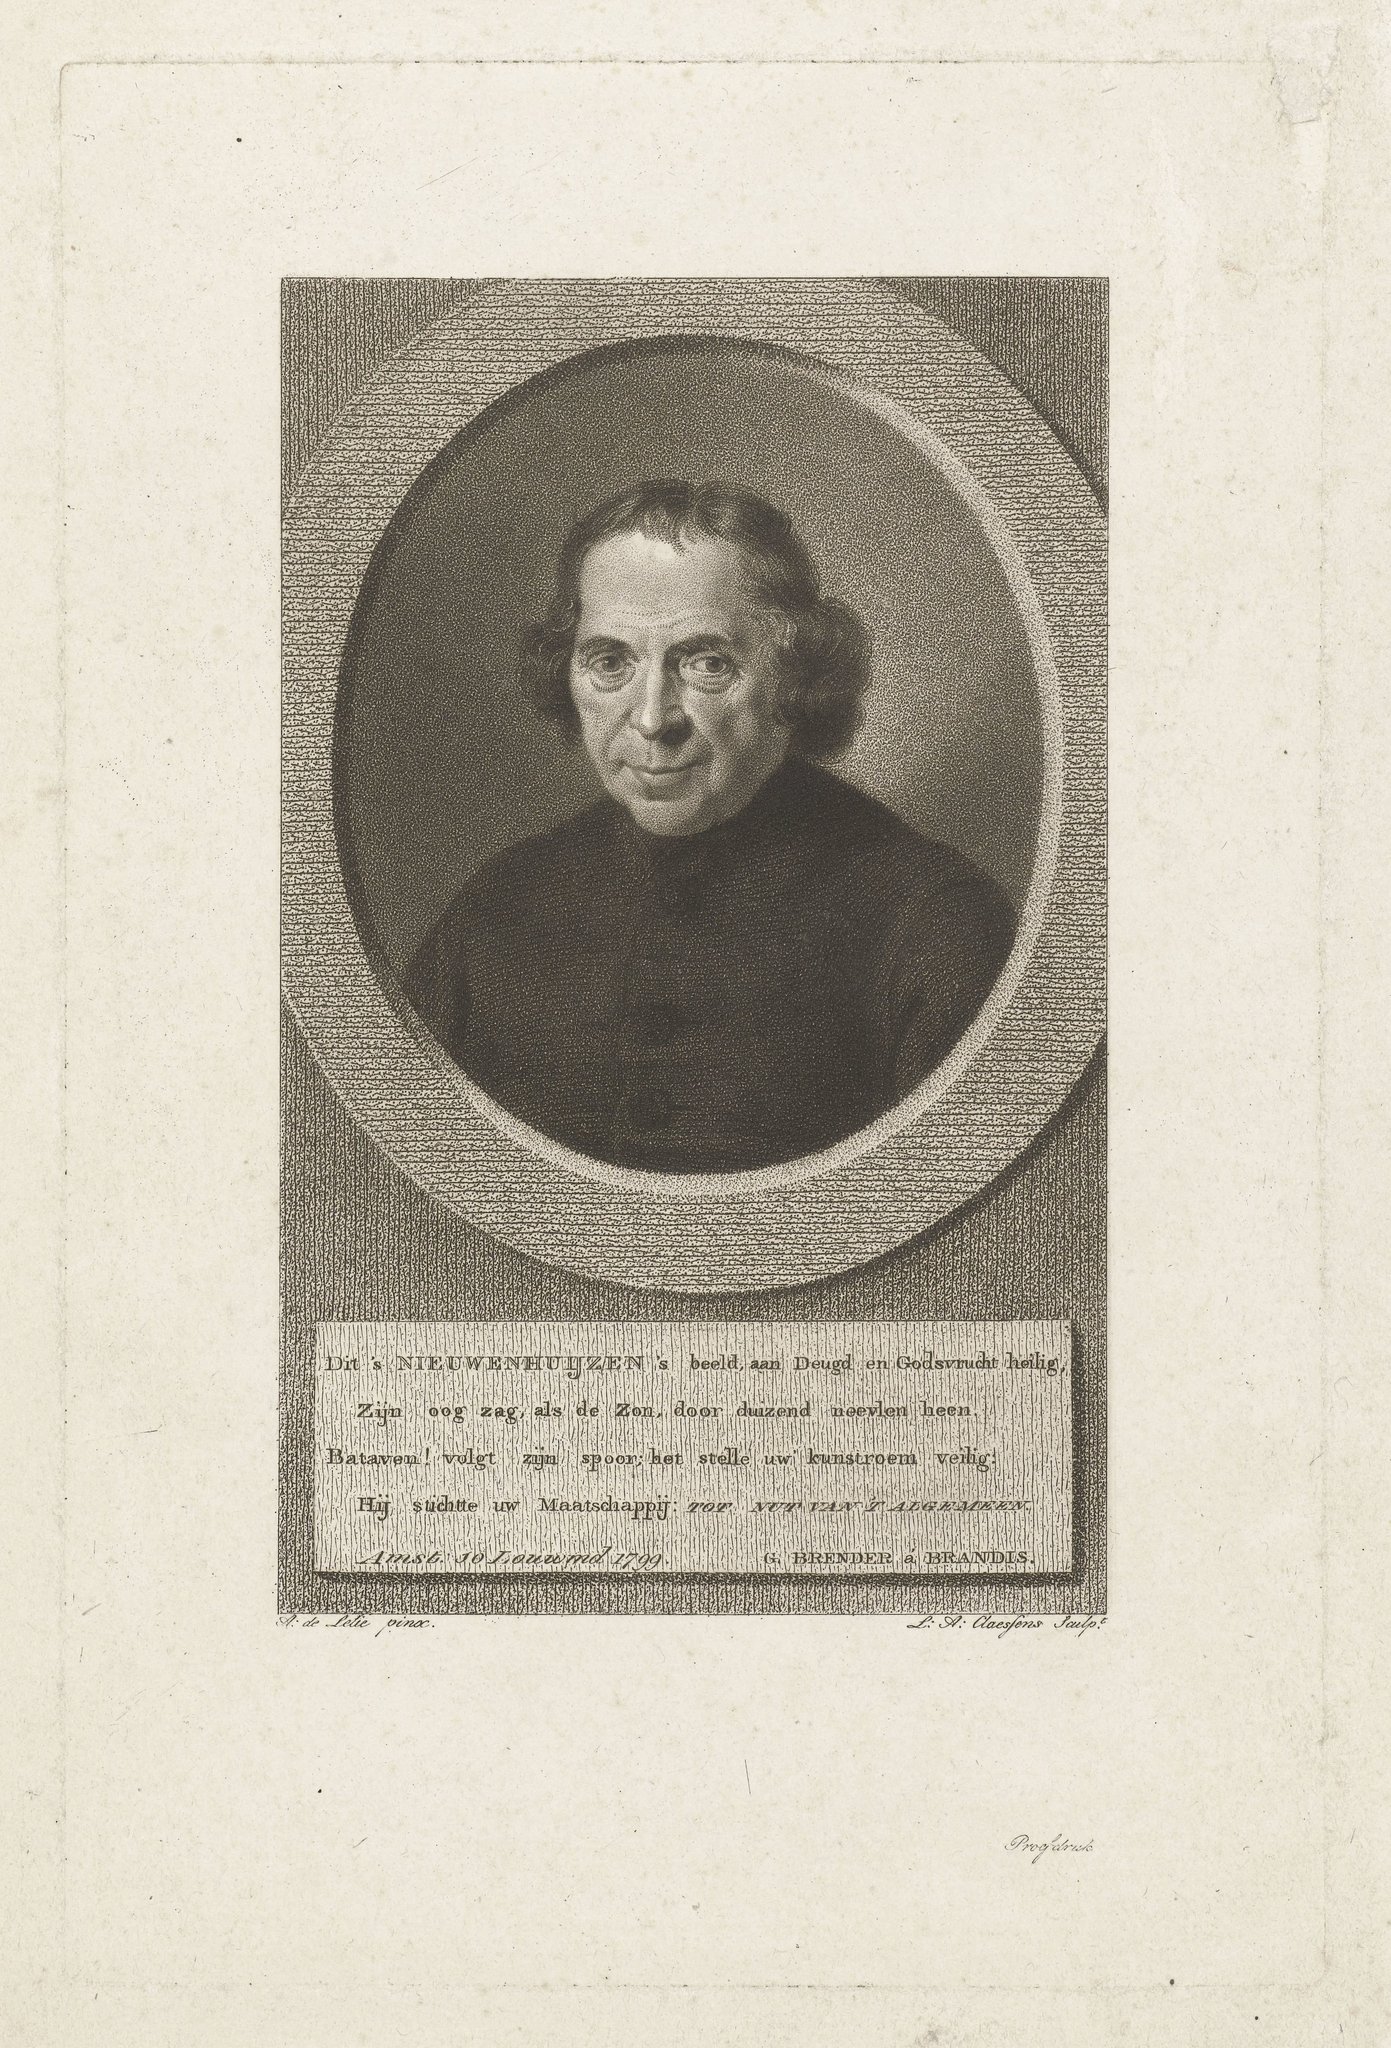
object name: print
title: Portret van de predikant Jan Nieuwenhuyzen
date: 1799-1808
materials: paper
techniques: engraving, etching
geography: amsterdam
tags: haarlem, amsterdam, jan nieuwenhuyzen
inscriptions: collector's mark: Lugt 2228